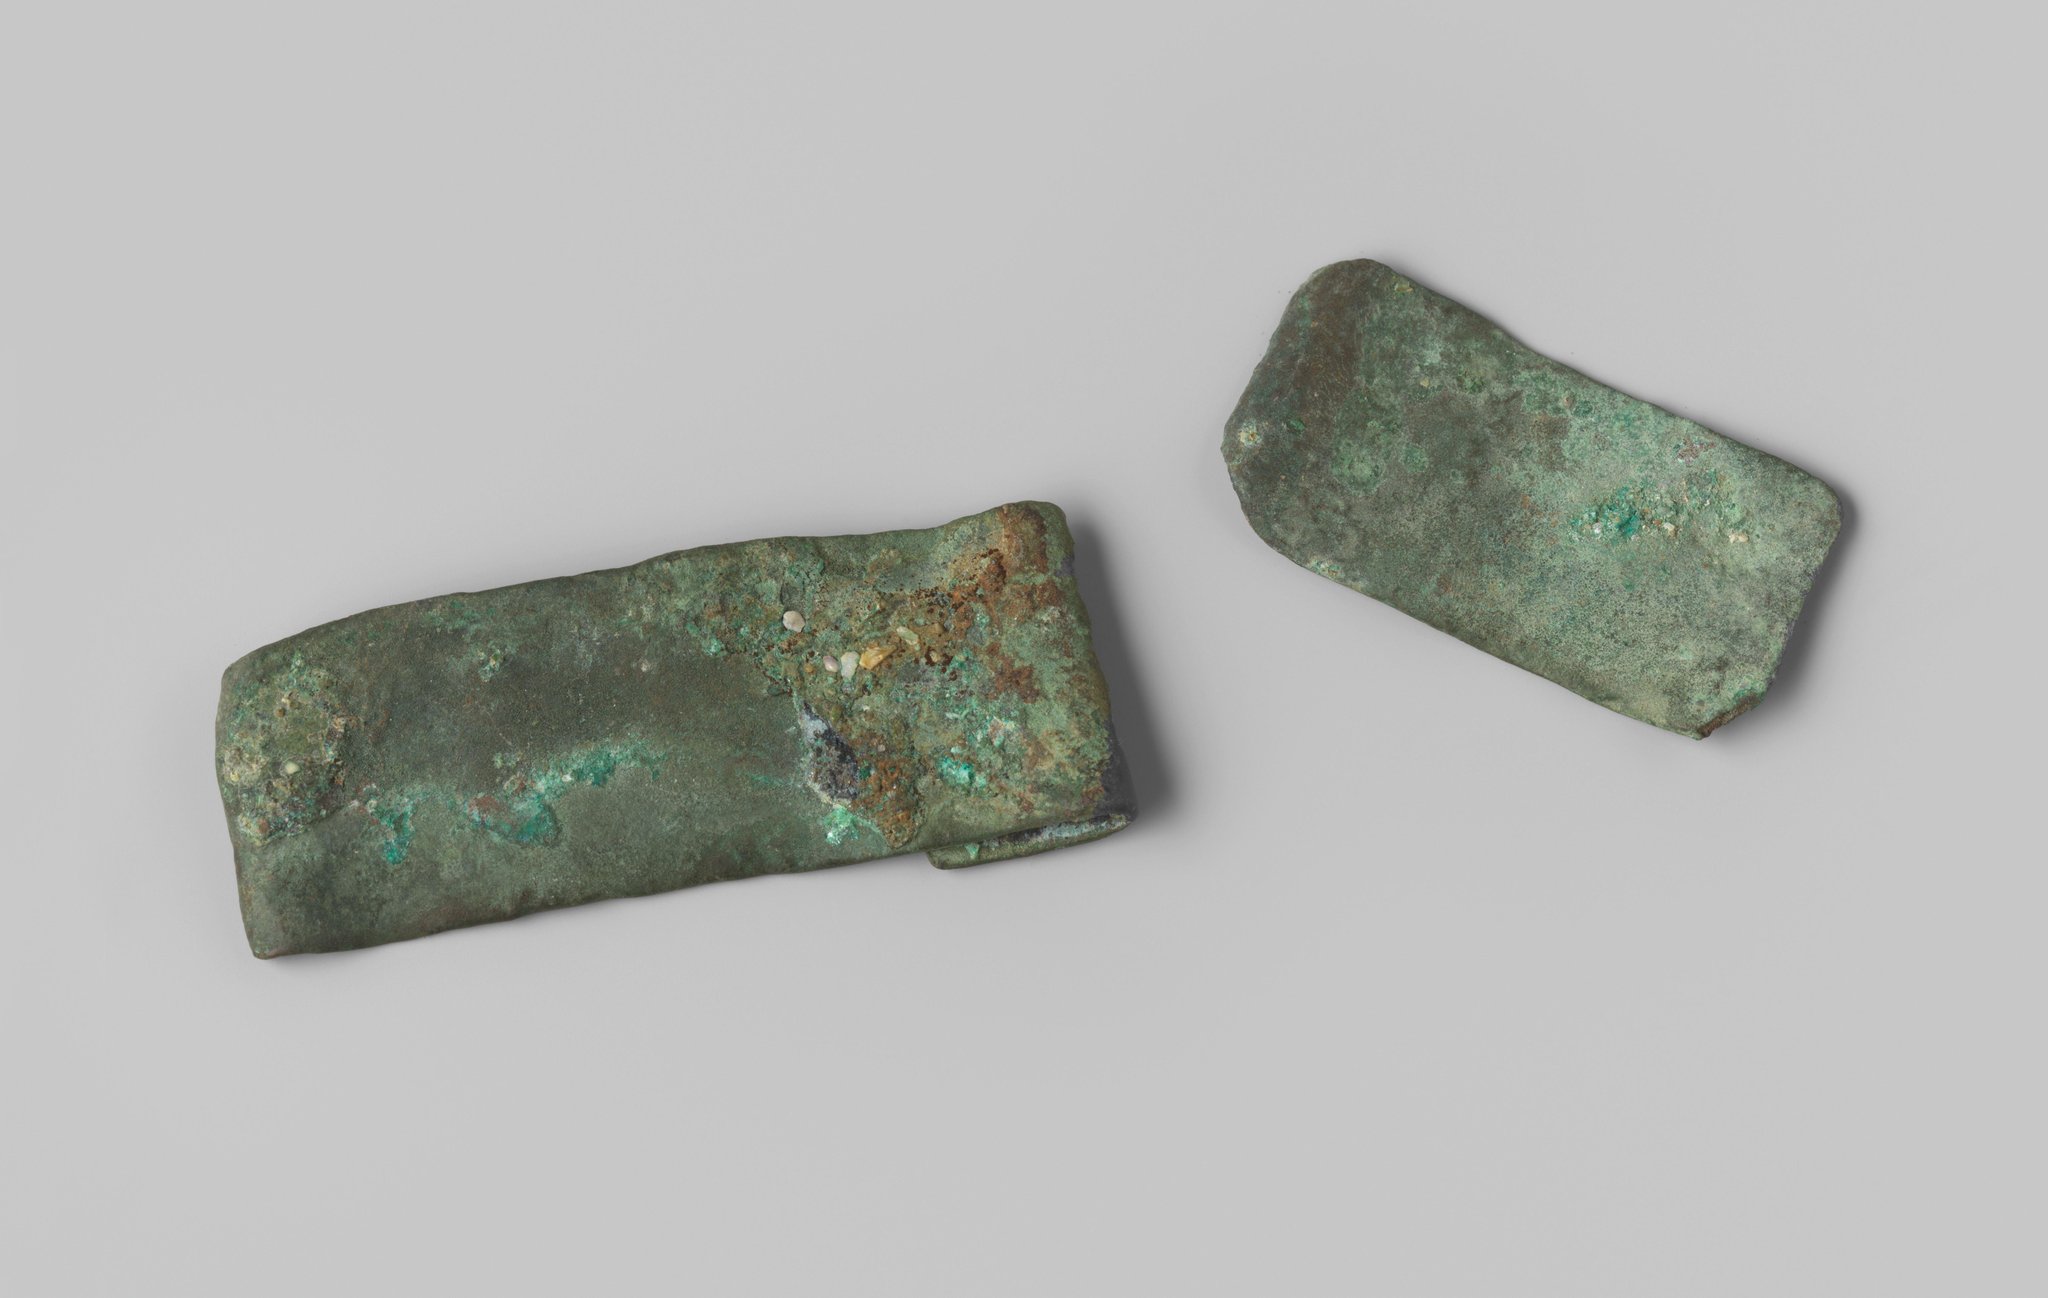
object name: firehose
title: Fragmenten van een brandslangring uit het wrak van de Oost-Indiëvaarder Hollandia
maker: Anonymous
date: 1700-1743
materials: copper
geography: netherlands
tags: verenigde oostindische compagnie, hollandia (schip), annet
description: Fire engine, firehose; fragments, id. NG-1975-20-H-1271-a, squashed corroded.